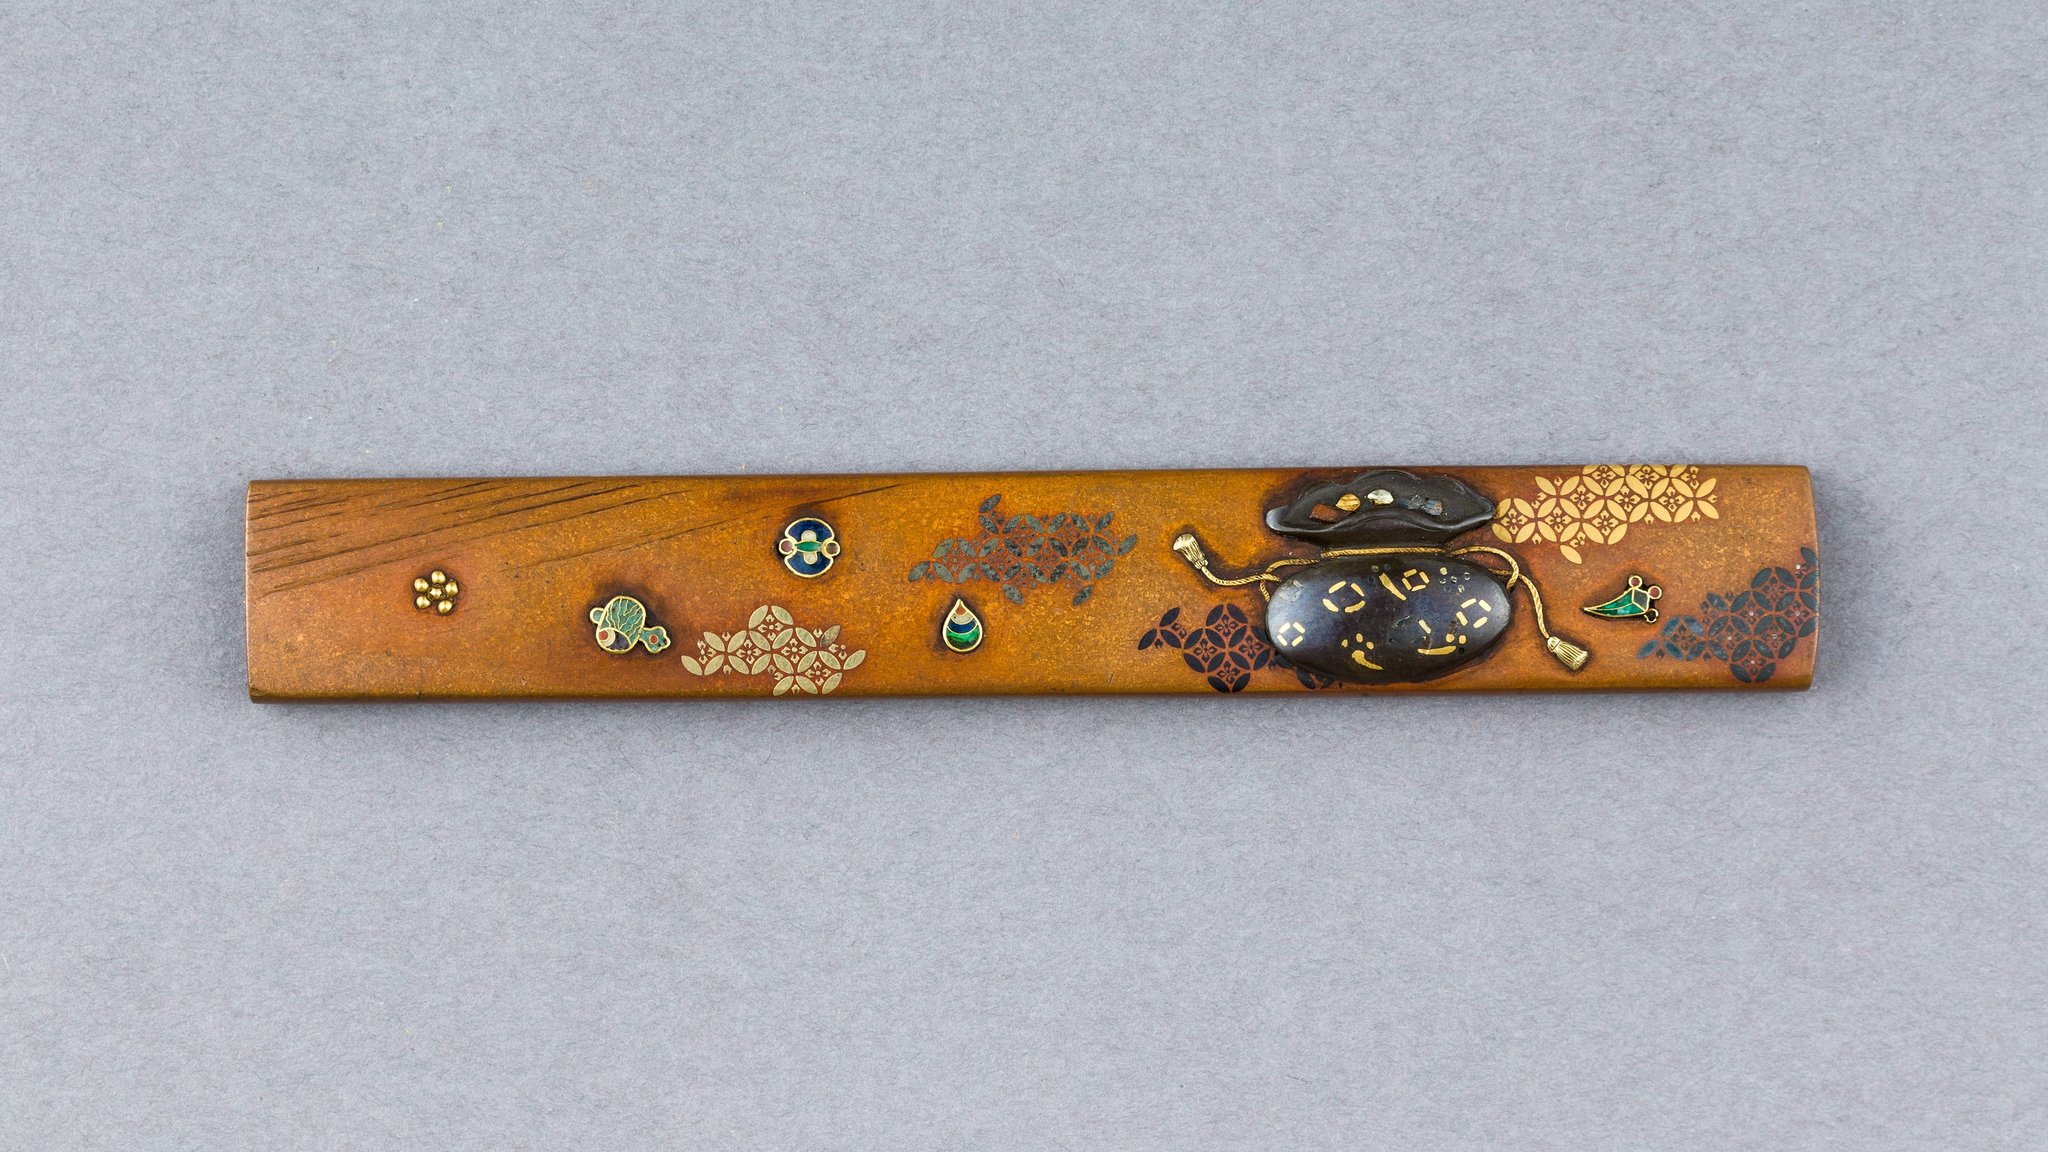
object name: knife handle kozuka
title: Knife Handle (Kozuka)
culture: japanese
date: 1801-1900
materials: copper, gold alloy, silver alloy, enamel, gold, silver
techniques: enamel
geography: japan